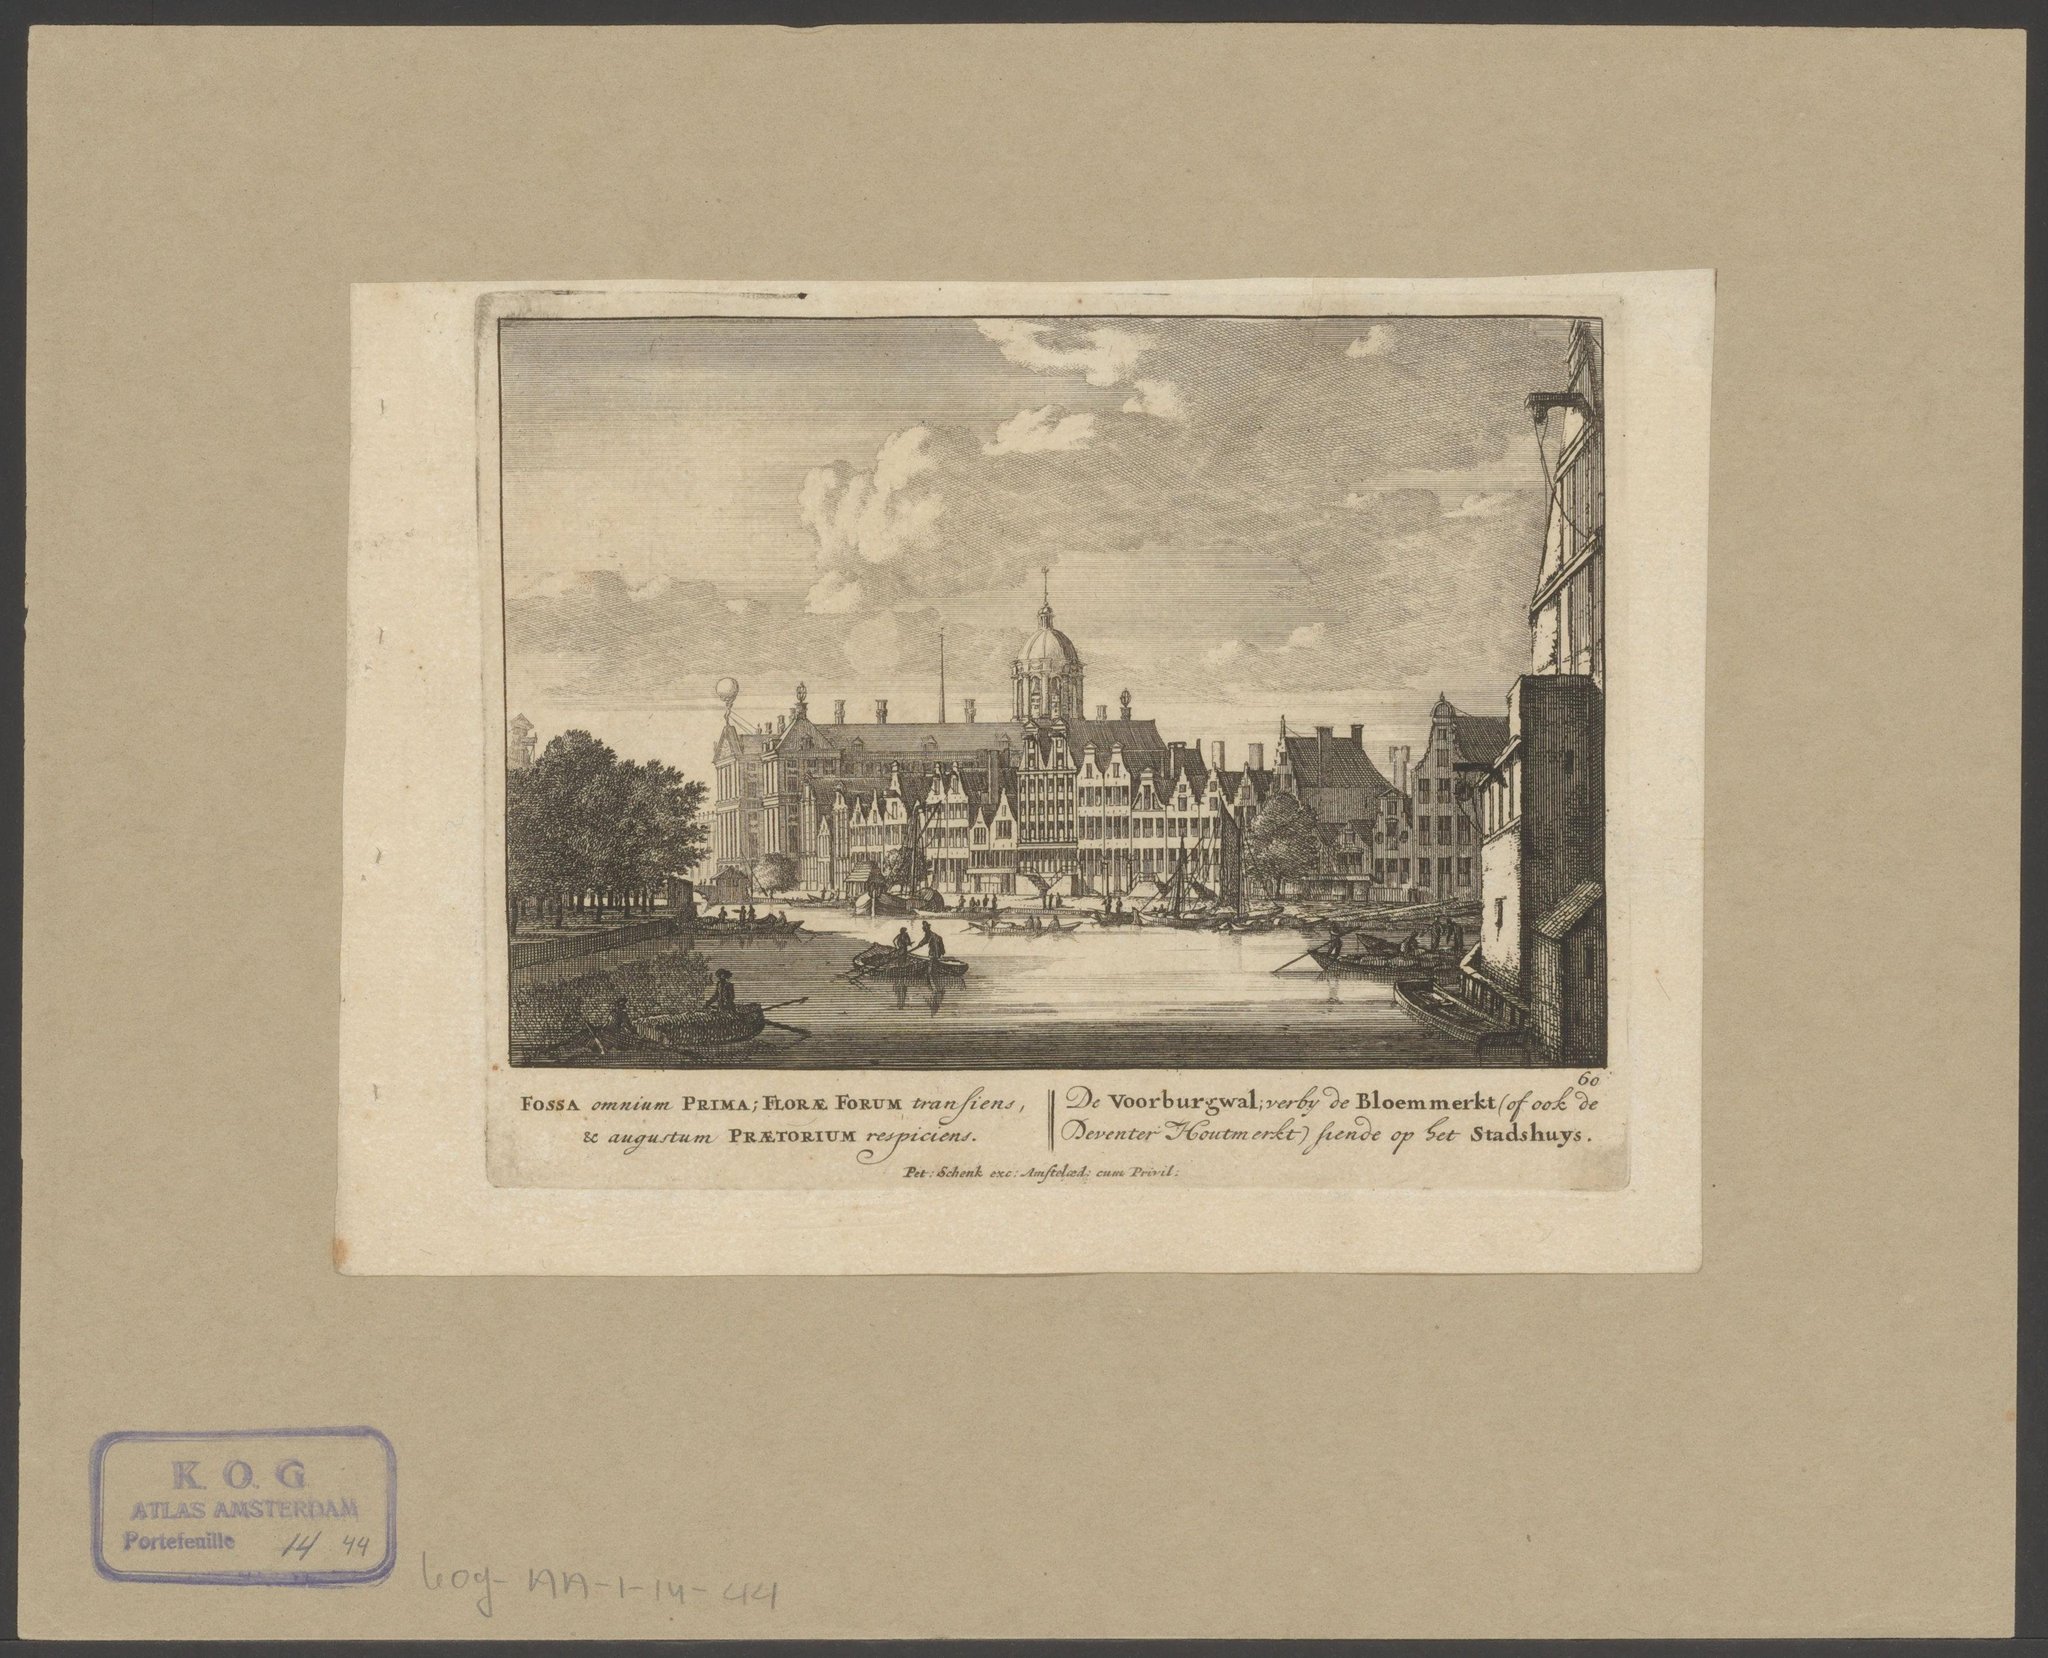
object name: print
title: Gezicht op de Nieuwezijds Voorburgwal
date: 1694-1697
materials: paper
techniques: etching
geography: amsterdam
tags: city-view in general; 'veduta', canal, townhall, boat propelled by man or animal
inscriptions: collector's mark: ‘14.44’ Lugt 1641b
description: Prent gebruikt in: Call, Jan van. Admirandorum Quadruplex Spectaculum. Amsterdam: Pieter Schenk (I), 1700. De titelprent, opdracht en het portret van Frederik van Saksen zijn gegraveerd door Pieter Schenk (I). De overige prenten uit deze serie zijn, zoals aangegeven op de titelprent, van de hand van Jan van Call (I).